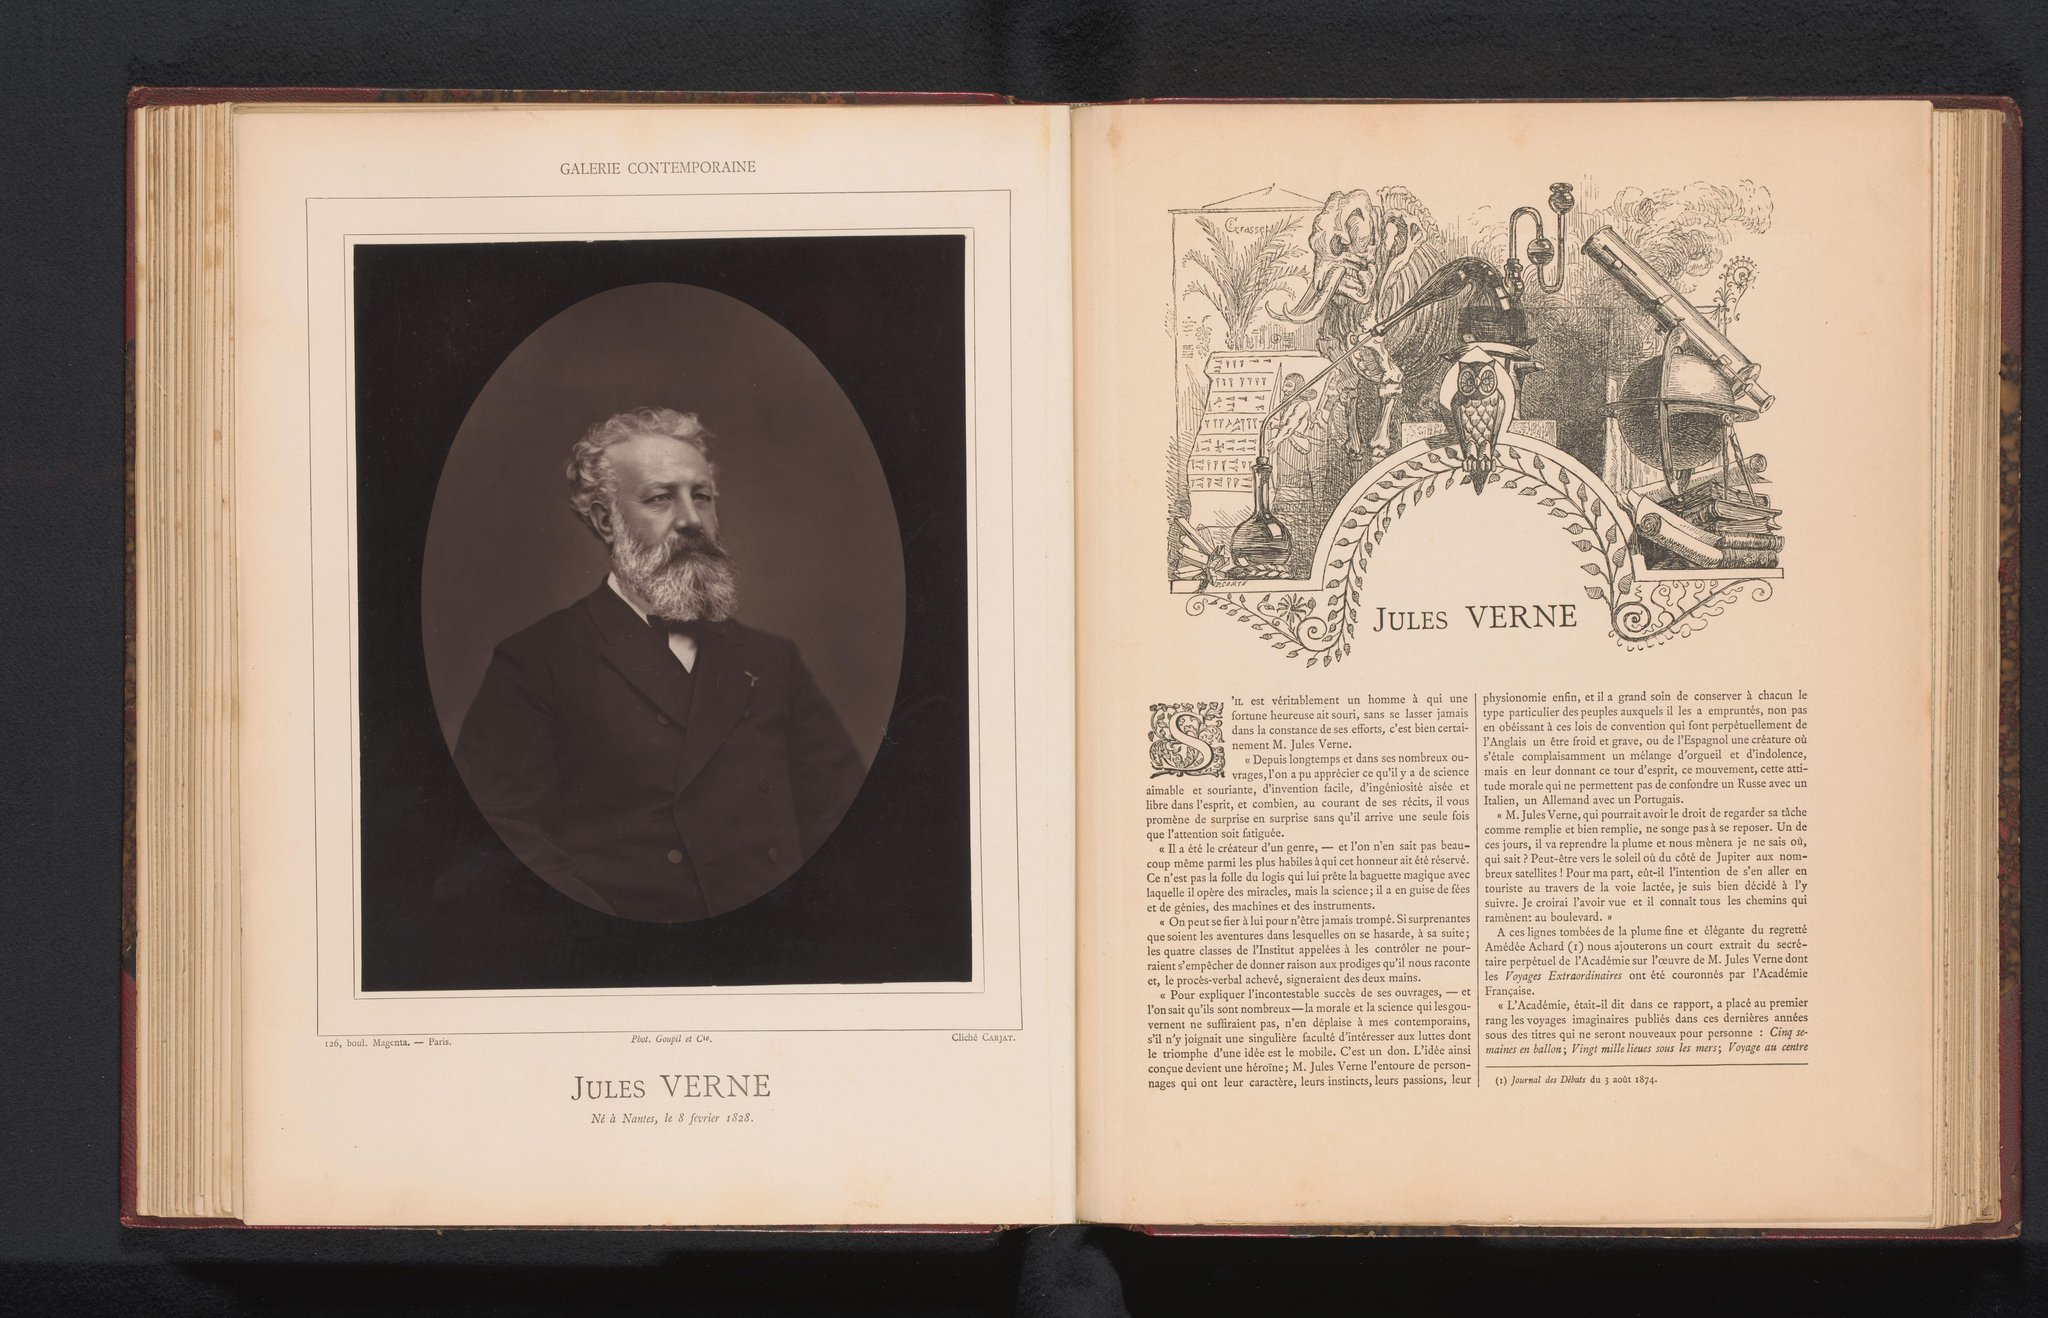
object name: photomechanical print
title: Jules Verne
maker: étienne carjat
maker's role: draughtsman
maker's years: 1828-1906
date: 1873-1878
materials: paper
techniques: woodburytype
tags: adult man, historical persons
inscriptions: inscription: ‘Galerie Contemporaine/ 126, boulevard Magenta. - Paris./ Né à Nantes, le 8 février 1828.’